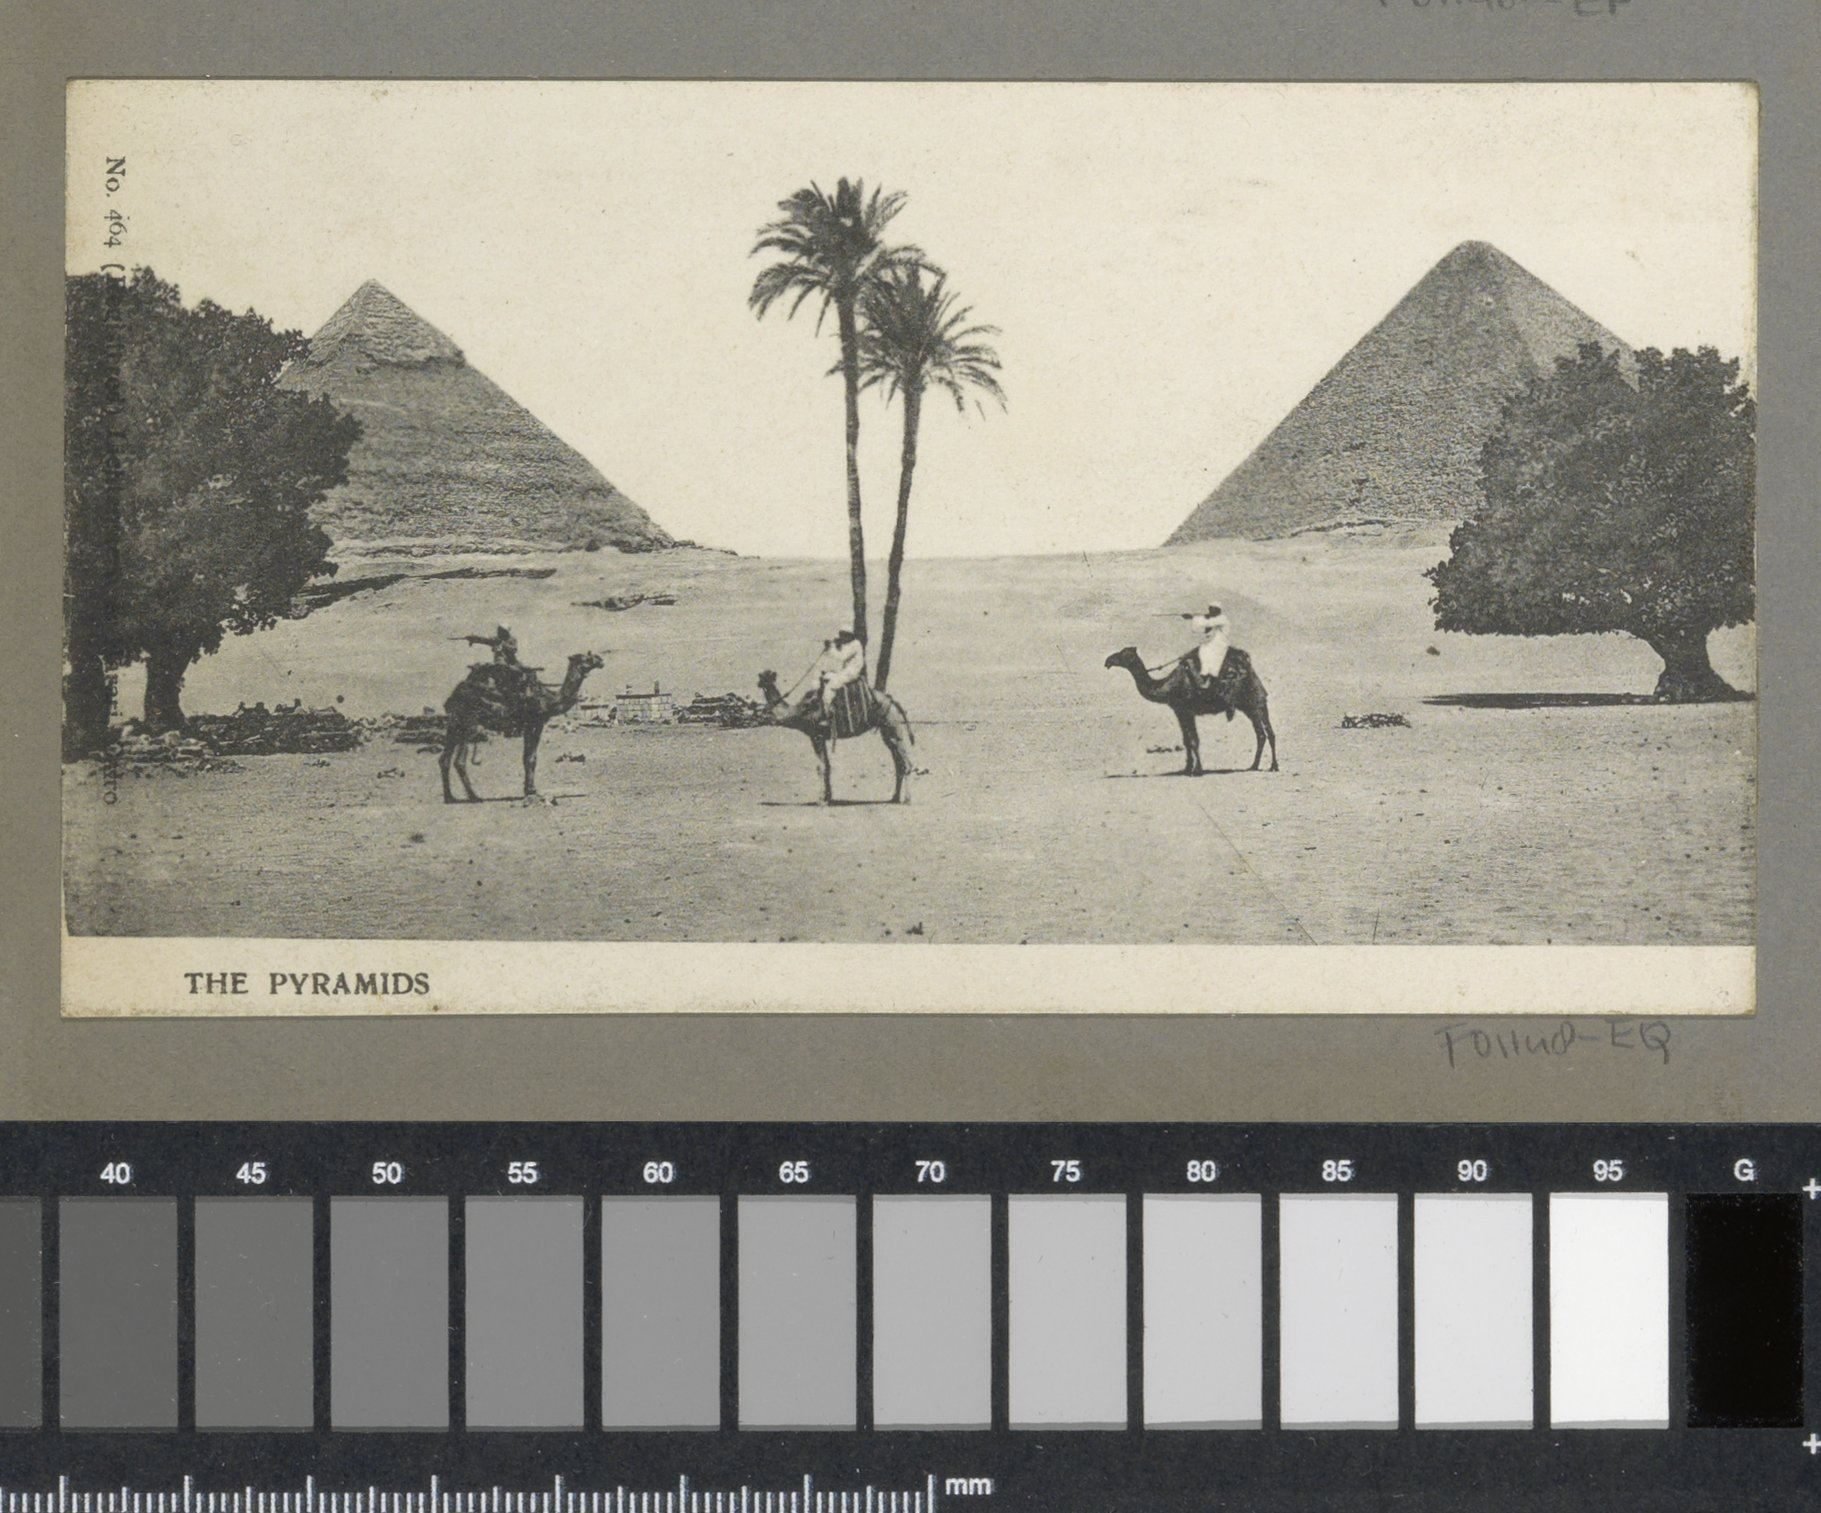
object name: album leaf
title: The pyramids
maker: Anonymous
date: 1895-1905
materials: paper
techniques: photograph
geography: egypt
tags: hoofed animals, pyramid (historical grave form)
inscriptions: number: ‘No. 464 R[...] Cairo.’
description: Onderdeel van Reisalbum met foto's van bezienswaardigheden in Griekenland en Egypte.